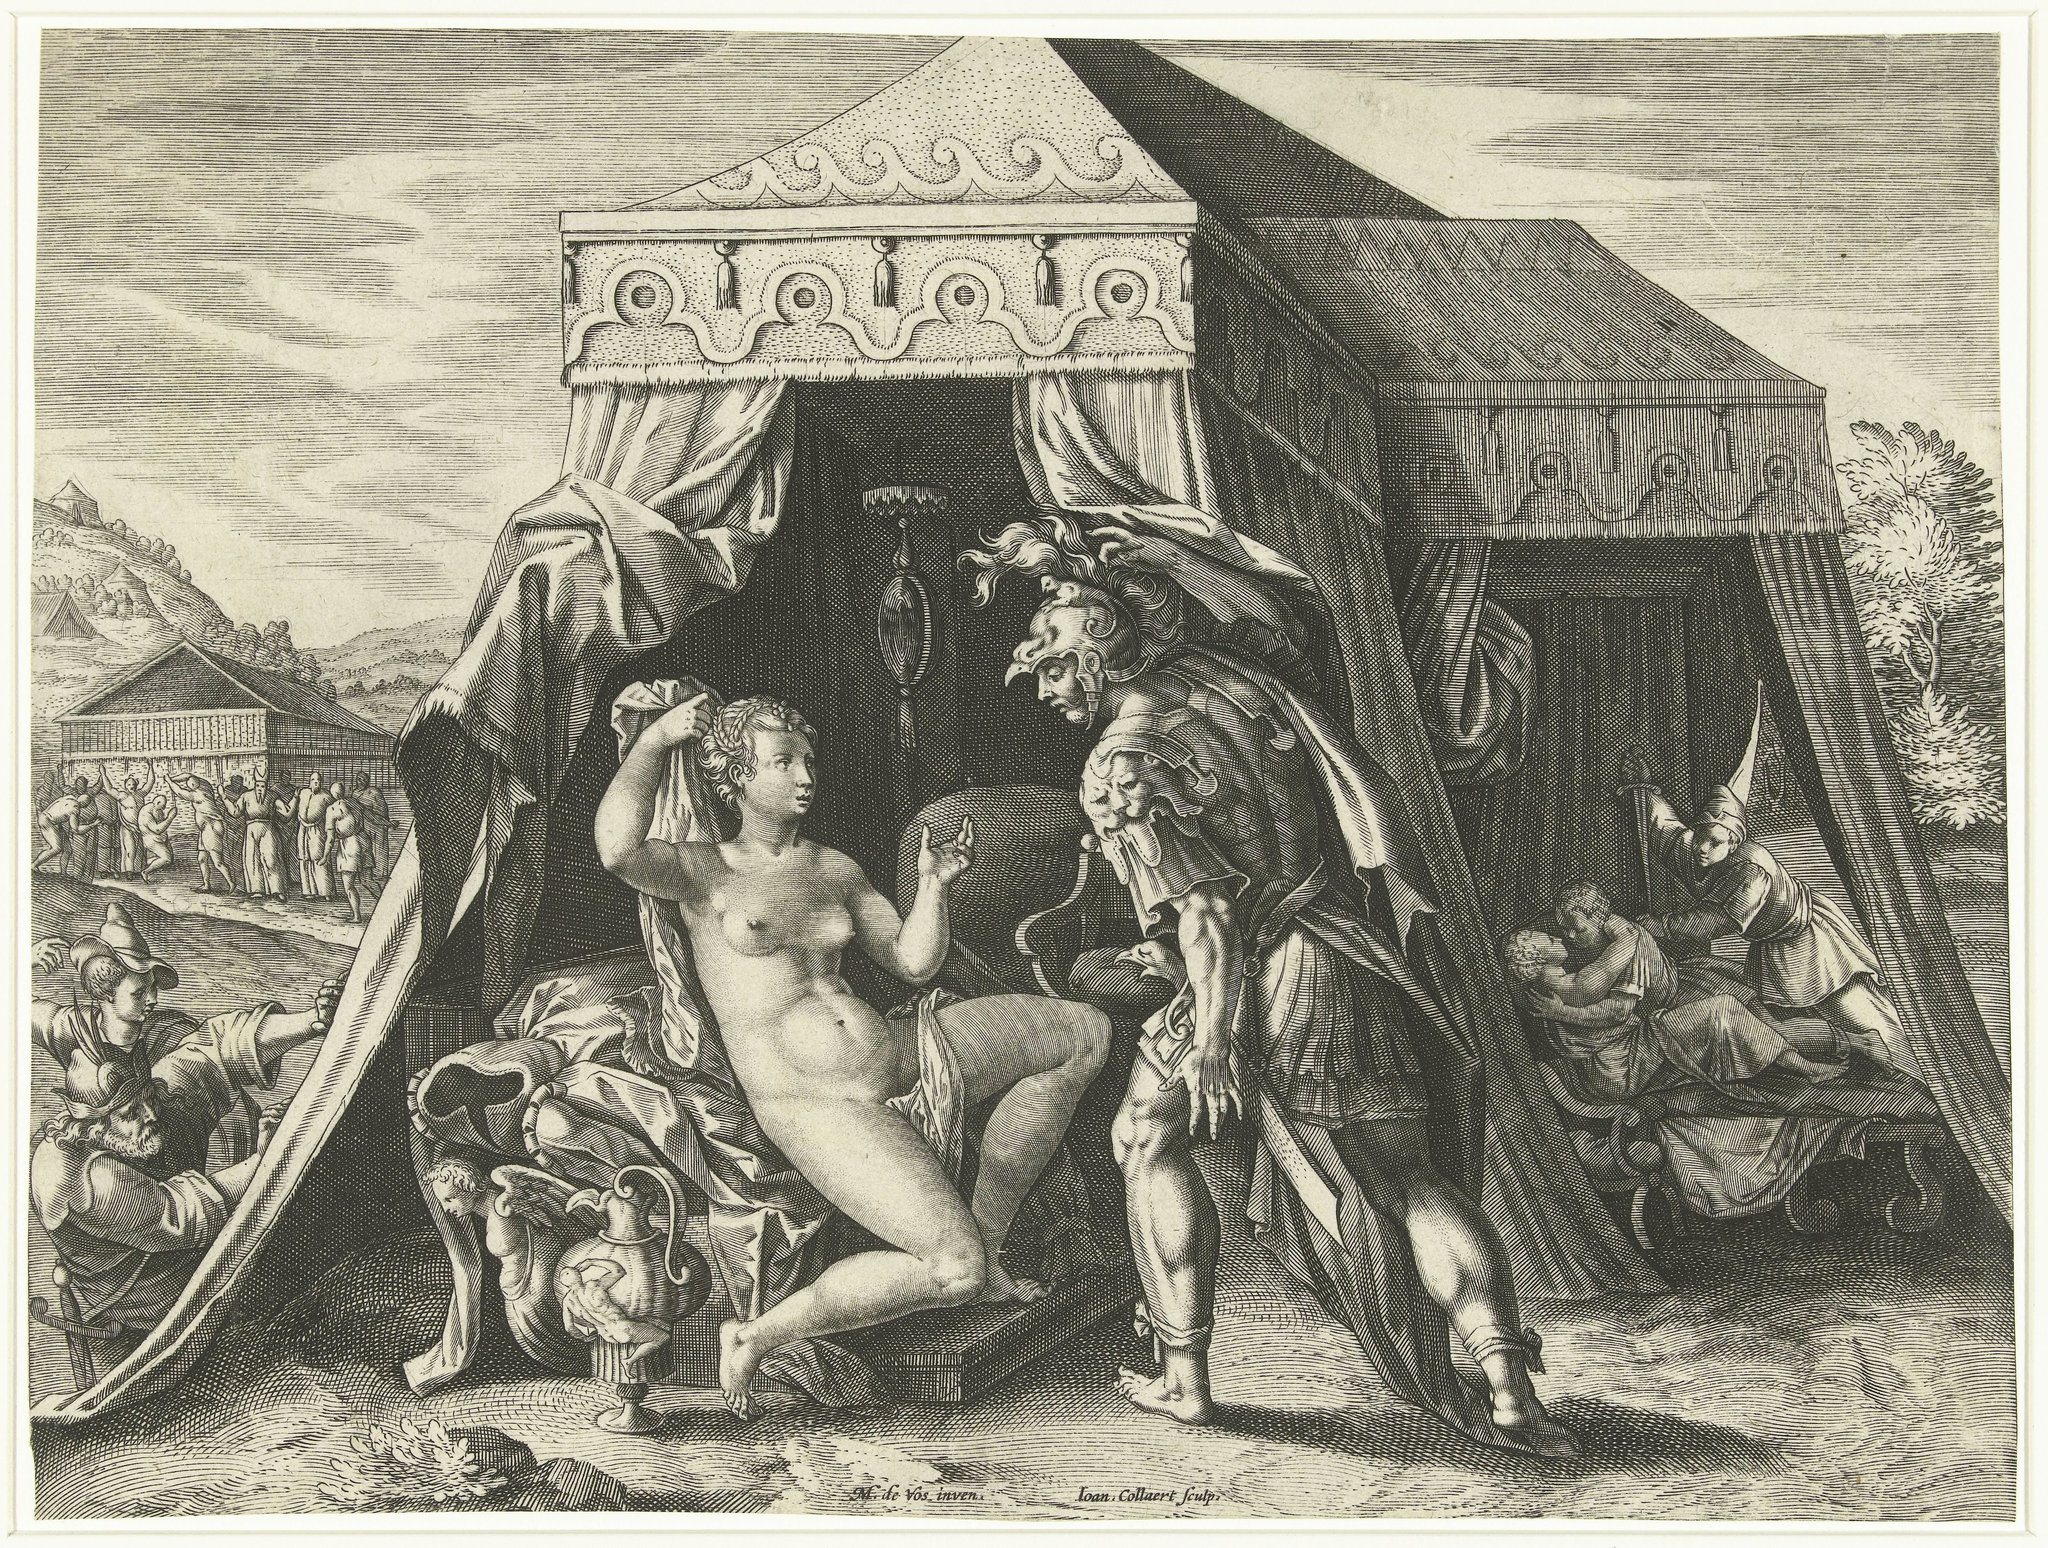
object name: print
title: Decalogvs cvm acerbissimis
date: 1585-1589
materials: paper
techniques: engraving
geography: antwerp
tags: phinehas, eleazar's son, follows zimri and cozbi and drives his spear through both of them, zimri takes a midianite woman, cozbi, into his tent, while the people are lamenting at the entrance of the tabernacle on account of an epidemic, 'you shall not commit adultery' ~ separate representation of the seventh of the ten commandments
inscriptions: collector's mark: Lugt 2228, collector's mark: Lugt 2760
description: Zimri, een leider van de Israëlieten, neemt Kozbi, een Midjanitische vrouw, mee naar zijn tent (Numeri 25: 6-8). Omdat zij van een ander volk was, is dit is een schending van het zesde Gebod: "Gij zult geen overspel plegen". Op de achtergrond hun straf: ze worden alletwee vermoord door de kleinzoon van Aäron. De prentserie beeldt de Tien Geboden uit door middel van scènes van het Oude Testament.